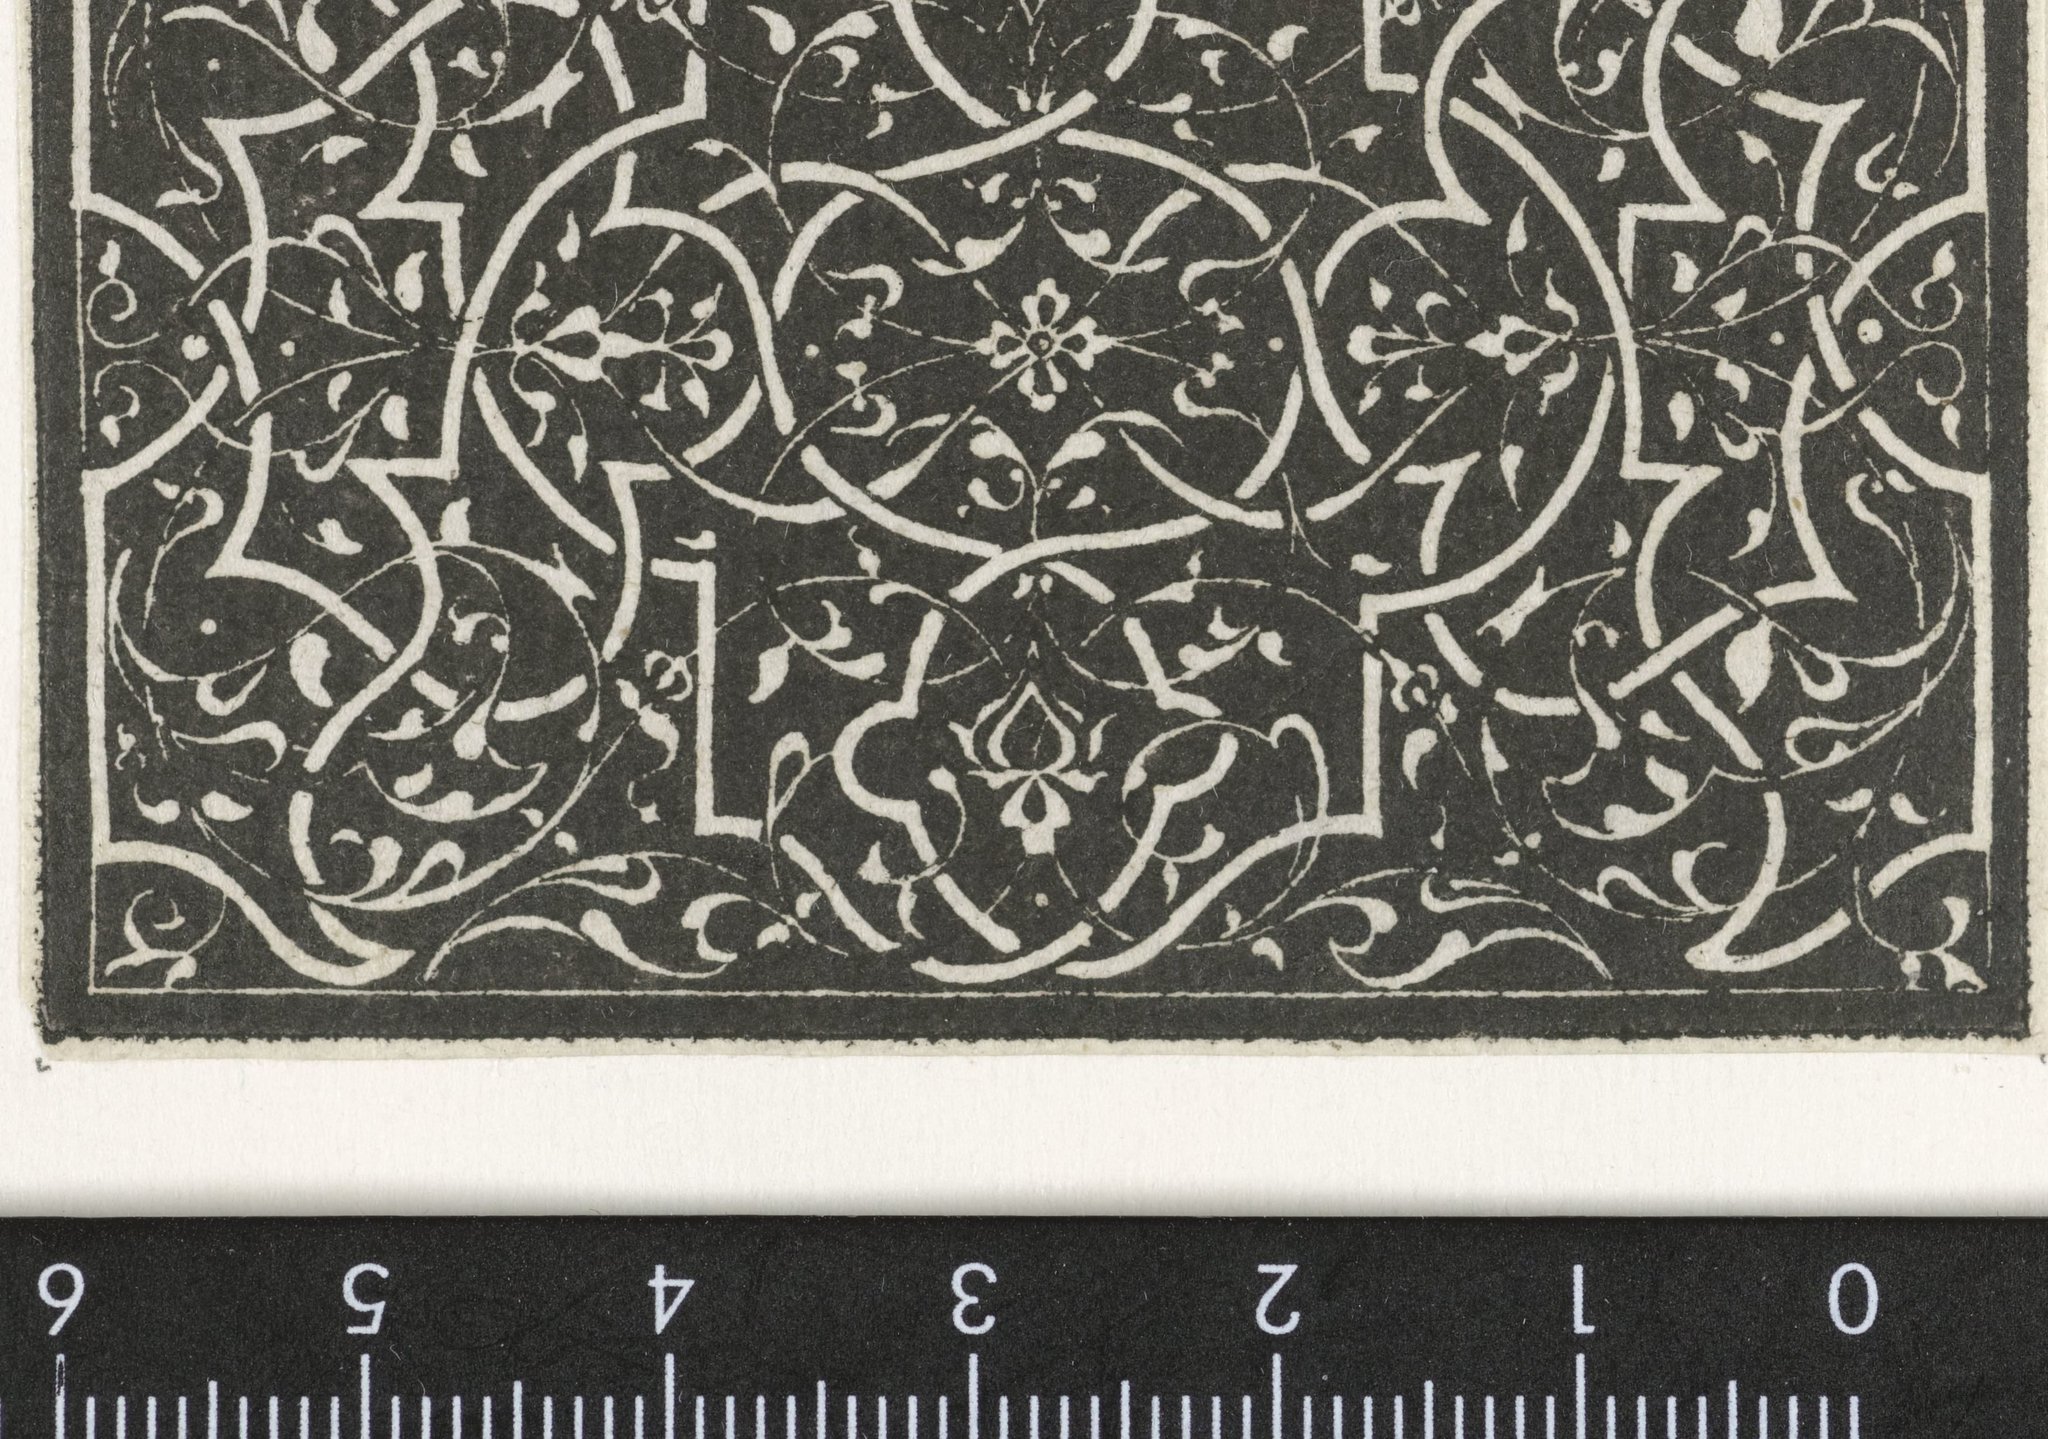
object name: ornament print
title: Vlakdecoraties met witte moresken en arabesken op een zwart fond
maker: Anonymous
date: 1516-1571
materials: paper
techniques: woodcut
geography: france